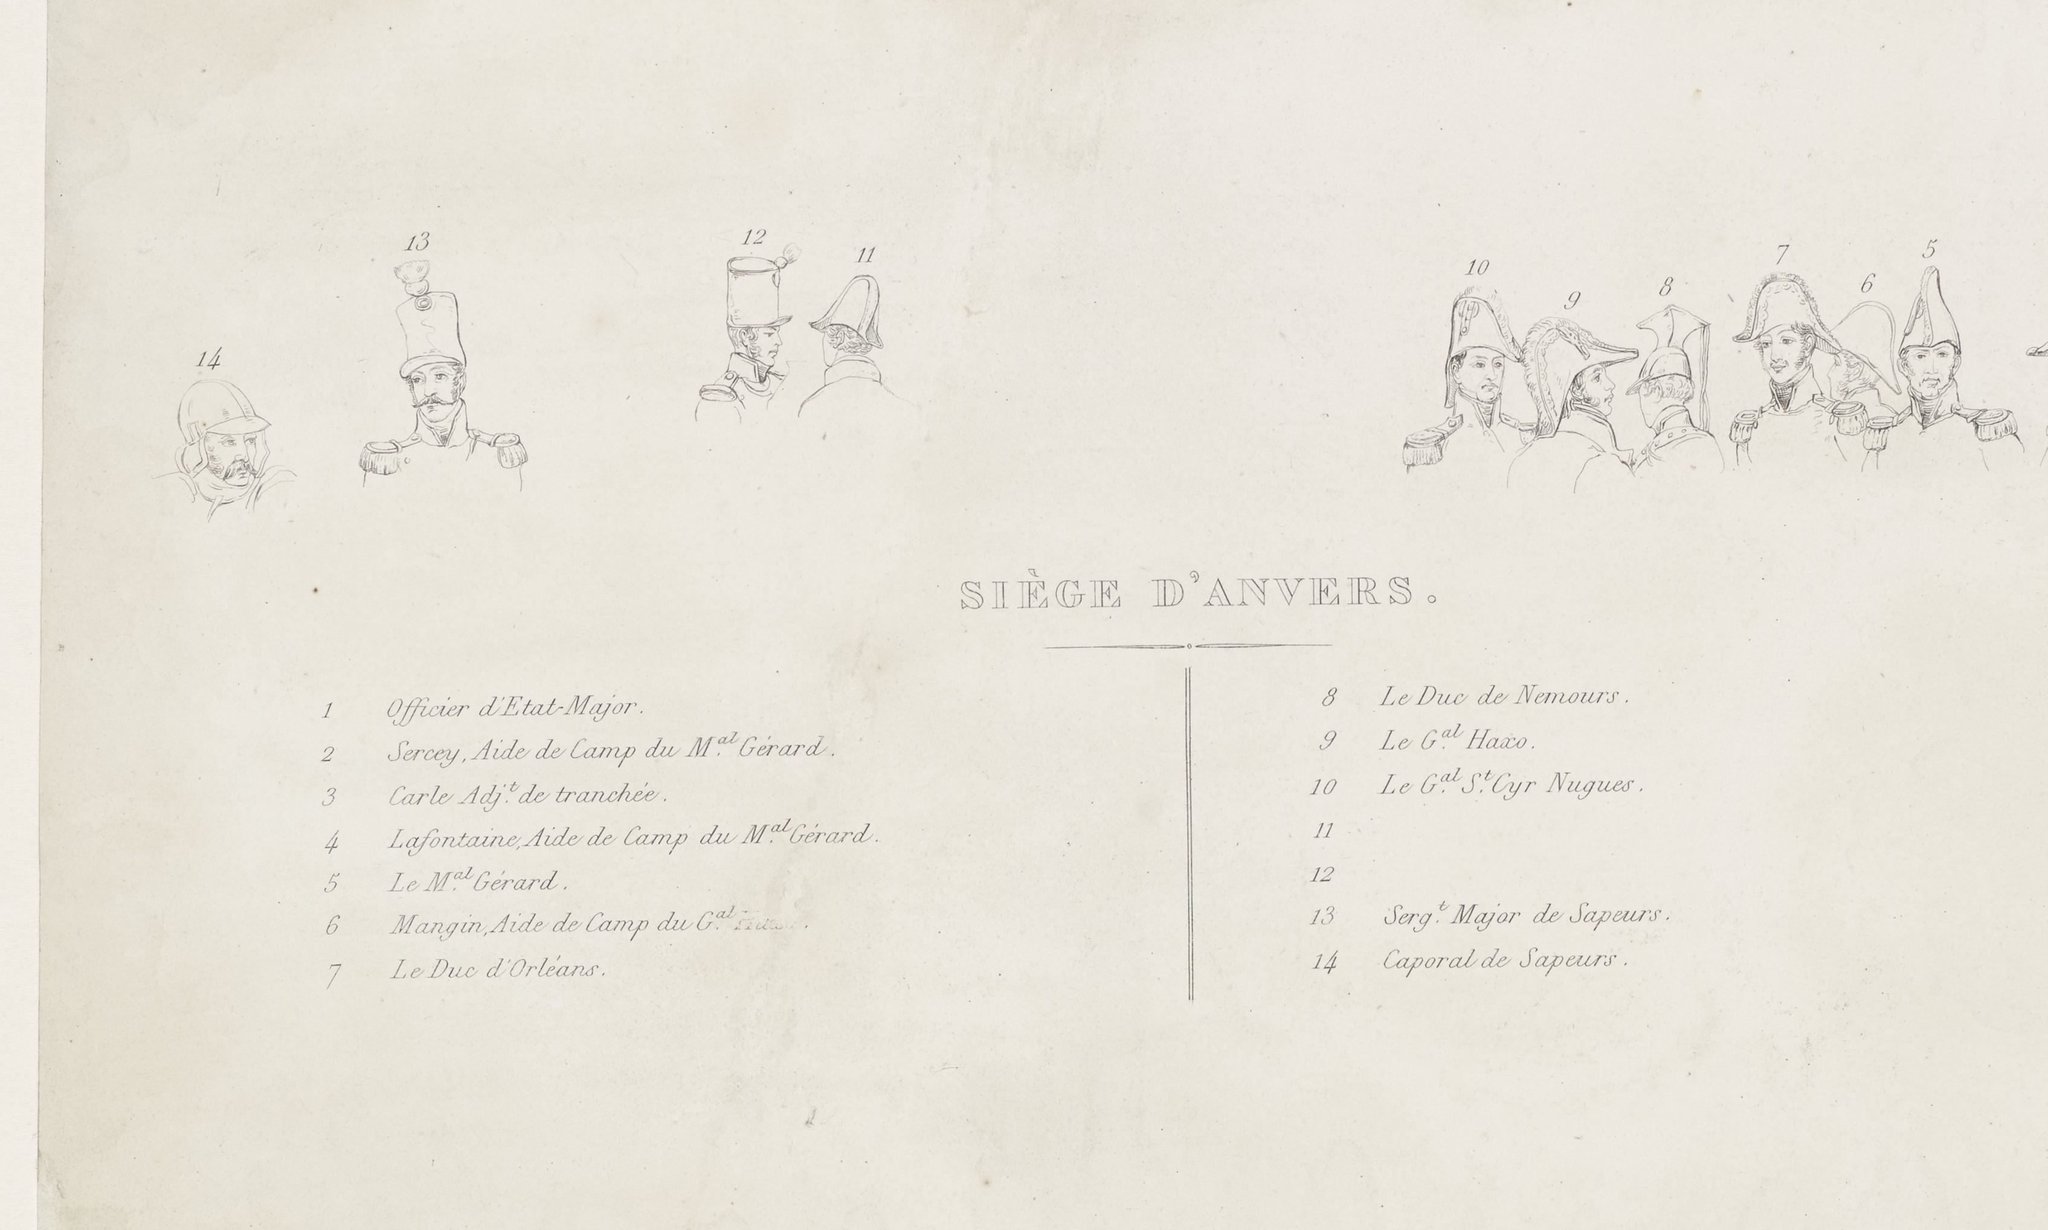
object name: print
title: Sleutel bij de prent van het Franse leger op de veroverde lunet van Saint-Laurent, 15 december 1832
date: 1832-1833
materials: paper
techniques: etching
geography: paris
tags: siege, position war, fortifications, military engineering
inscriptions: collector's mark: Lugt 2228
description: Sleutel behorende bij de prent van het Franse leger op de veroverde lunet van Saint-Laurent (Sint Laurens) op 15 december, tijdens het beleg van de Citadel van Antwerpen, november-december 1832. Met een lijst van de afgebeelde personen 1-14 in twee kolommen.